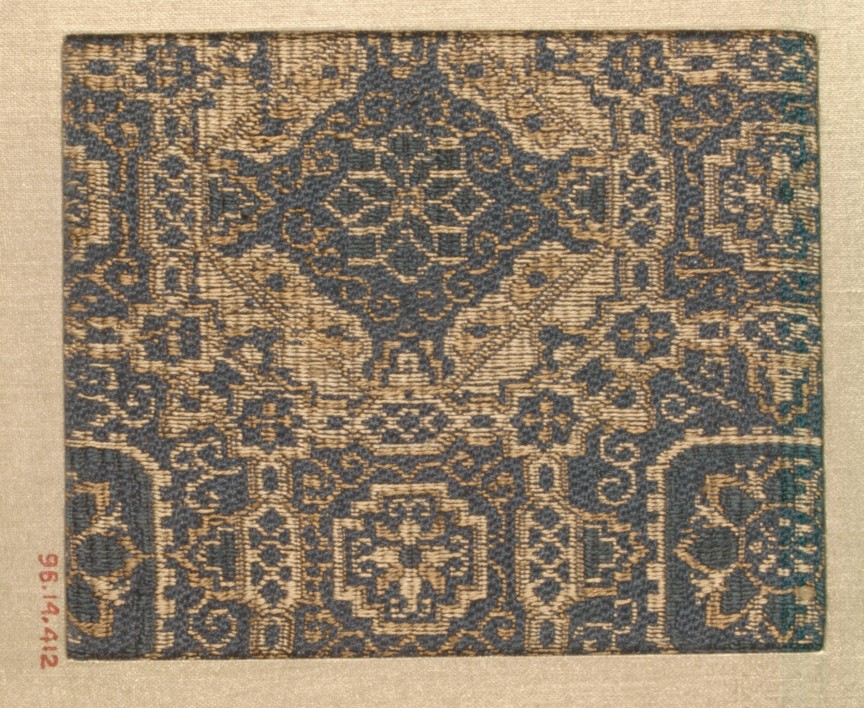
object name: piece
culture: japanese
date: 1701-1900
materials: silk